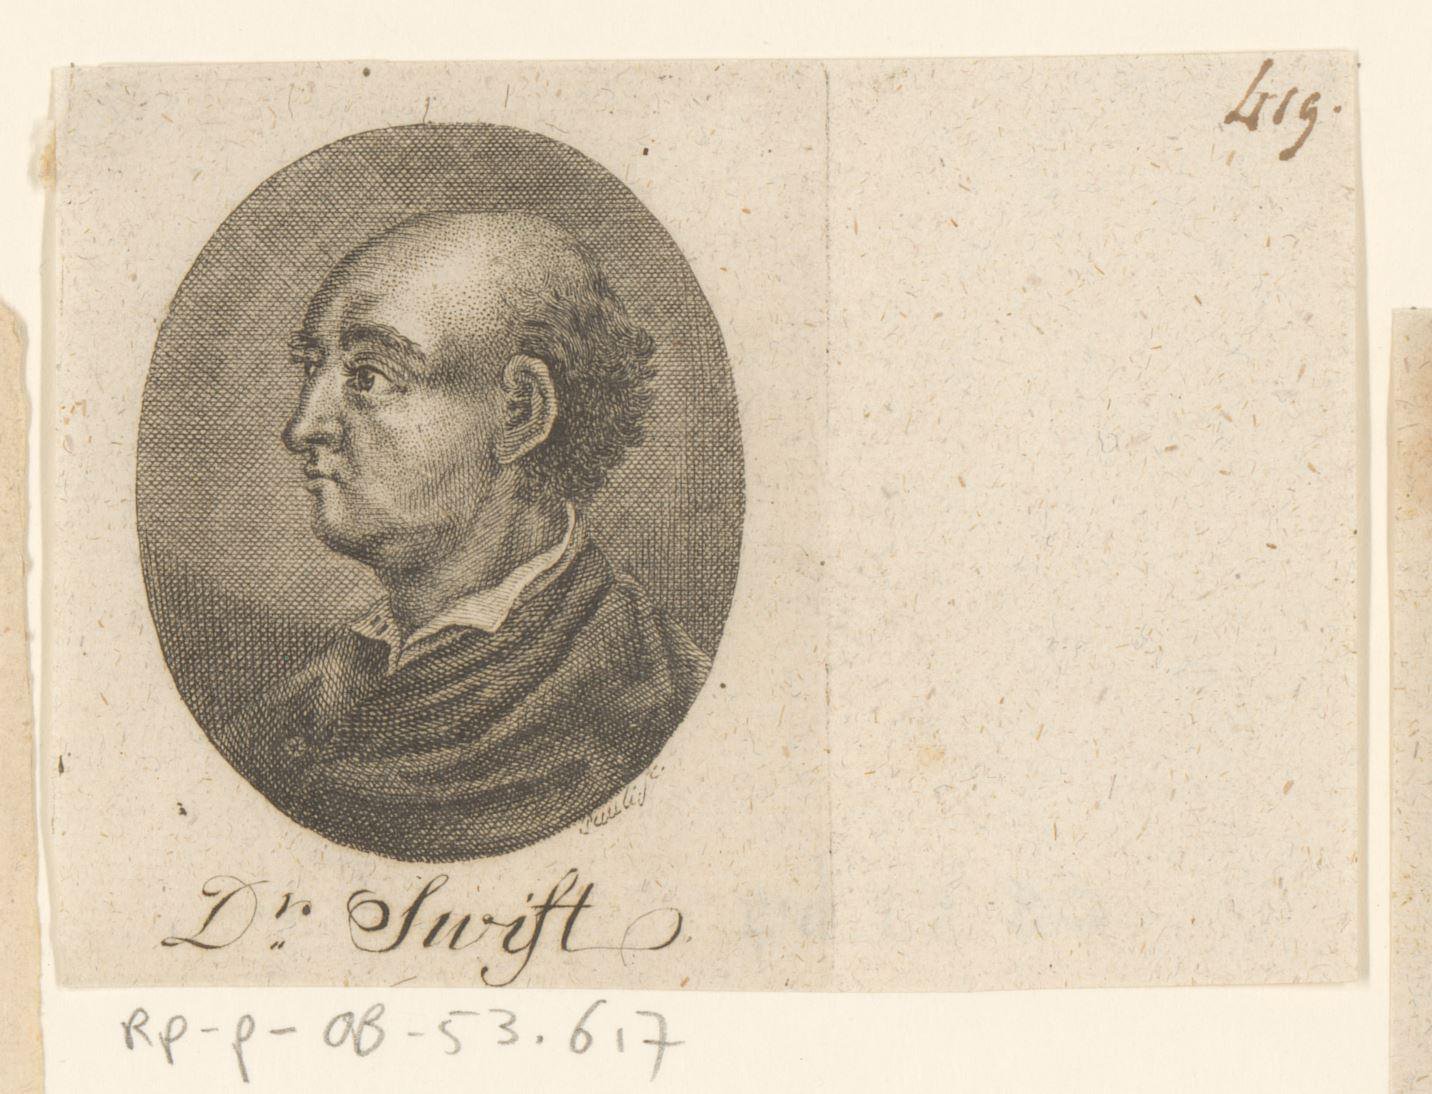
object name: print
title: Portret van Jonathan Swift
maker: jan willem paulus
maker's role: print maker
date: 1750-1849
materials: paper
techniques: engraving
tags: historical persons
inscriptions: number: ‘419.’